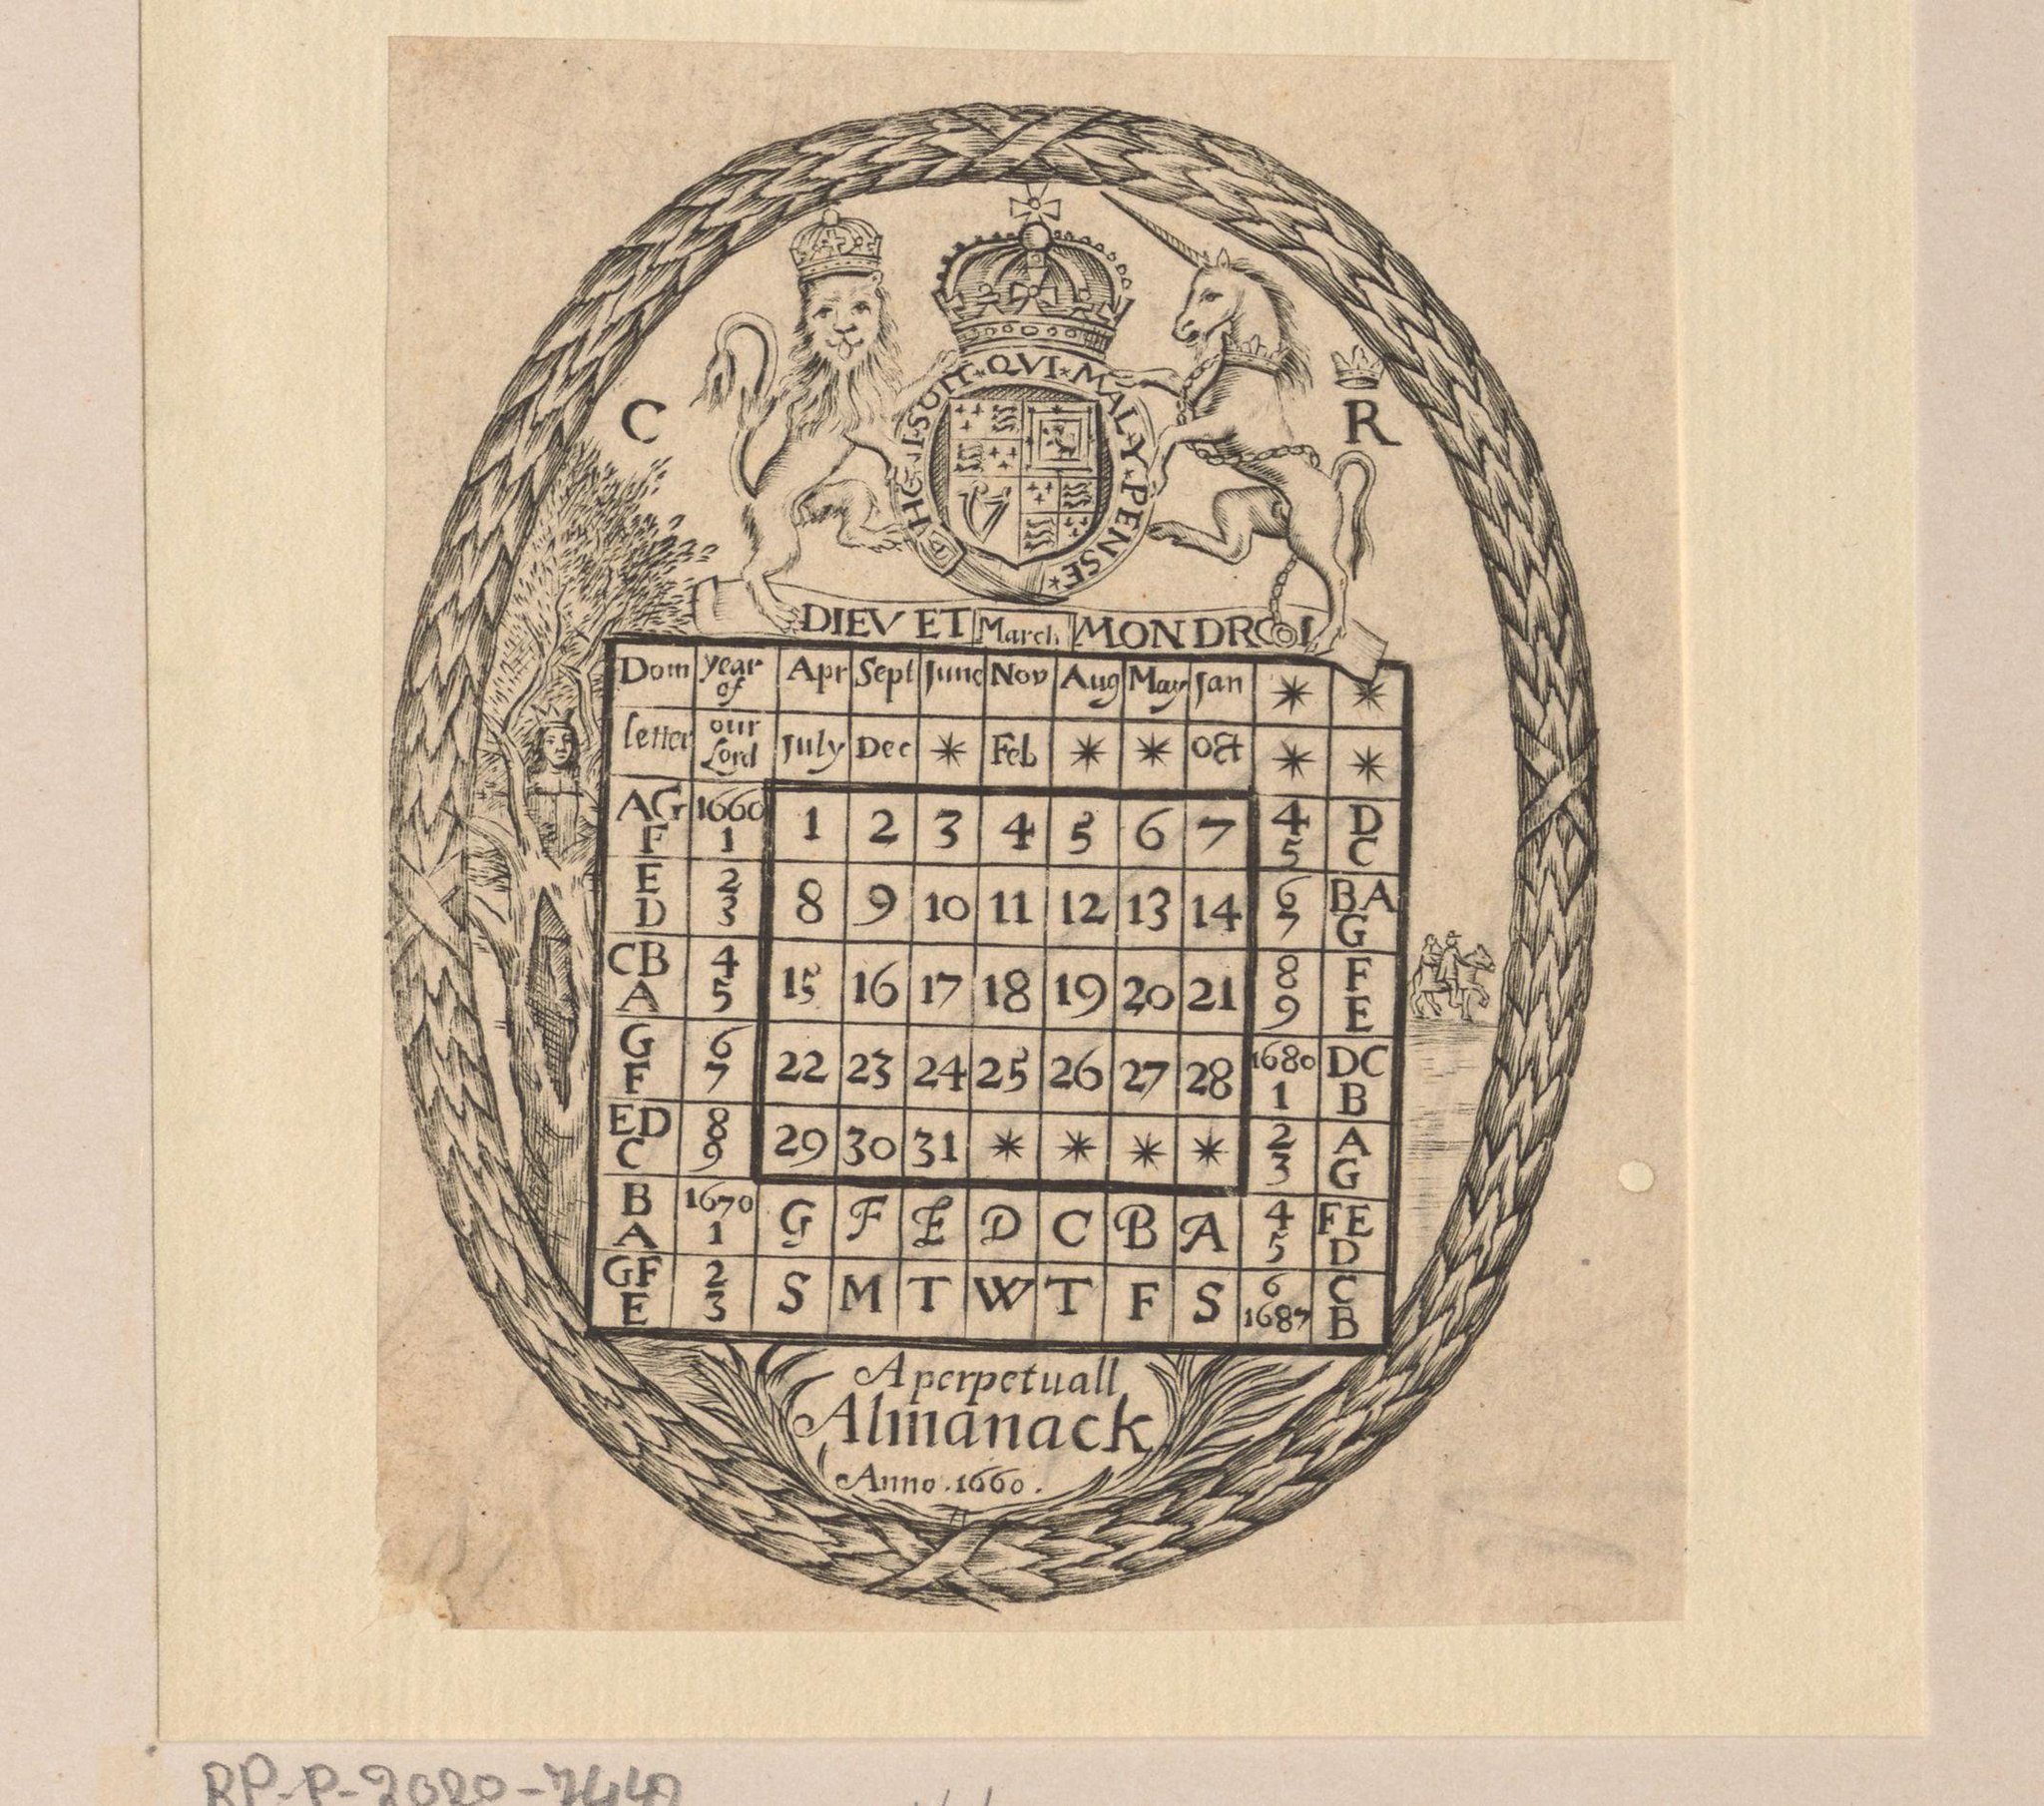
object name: print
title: Eeuwigdurende kalender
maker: Anonymous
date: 1660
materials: paper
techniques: engraving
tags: london, karel ii (koning van engeland), perpetual calendar, armorial bearing, heraldry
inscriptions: date